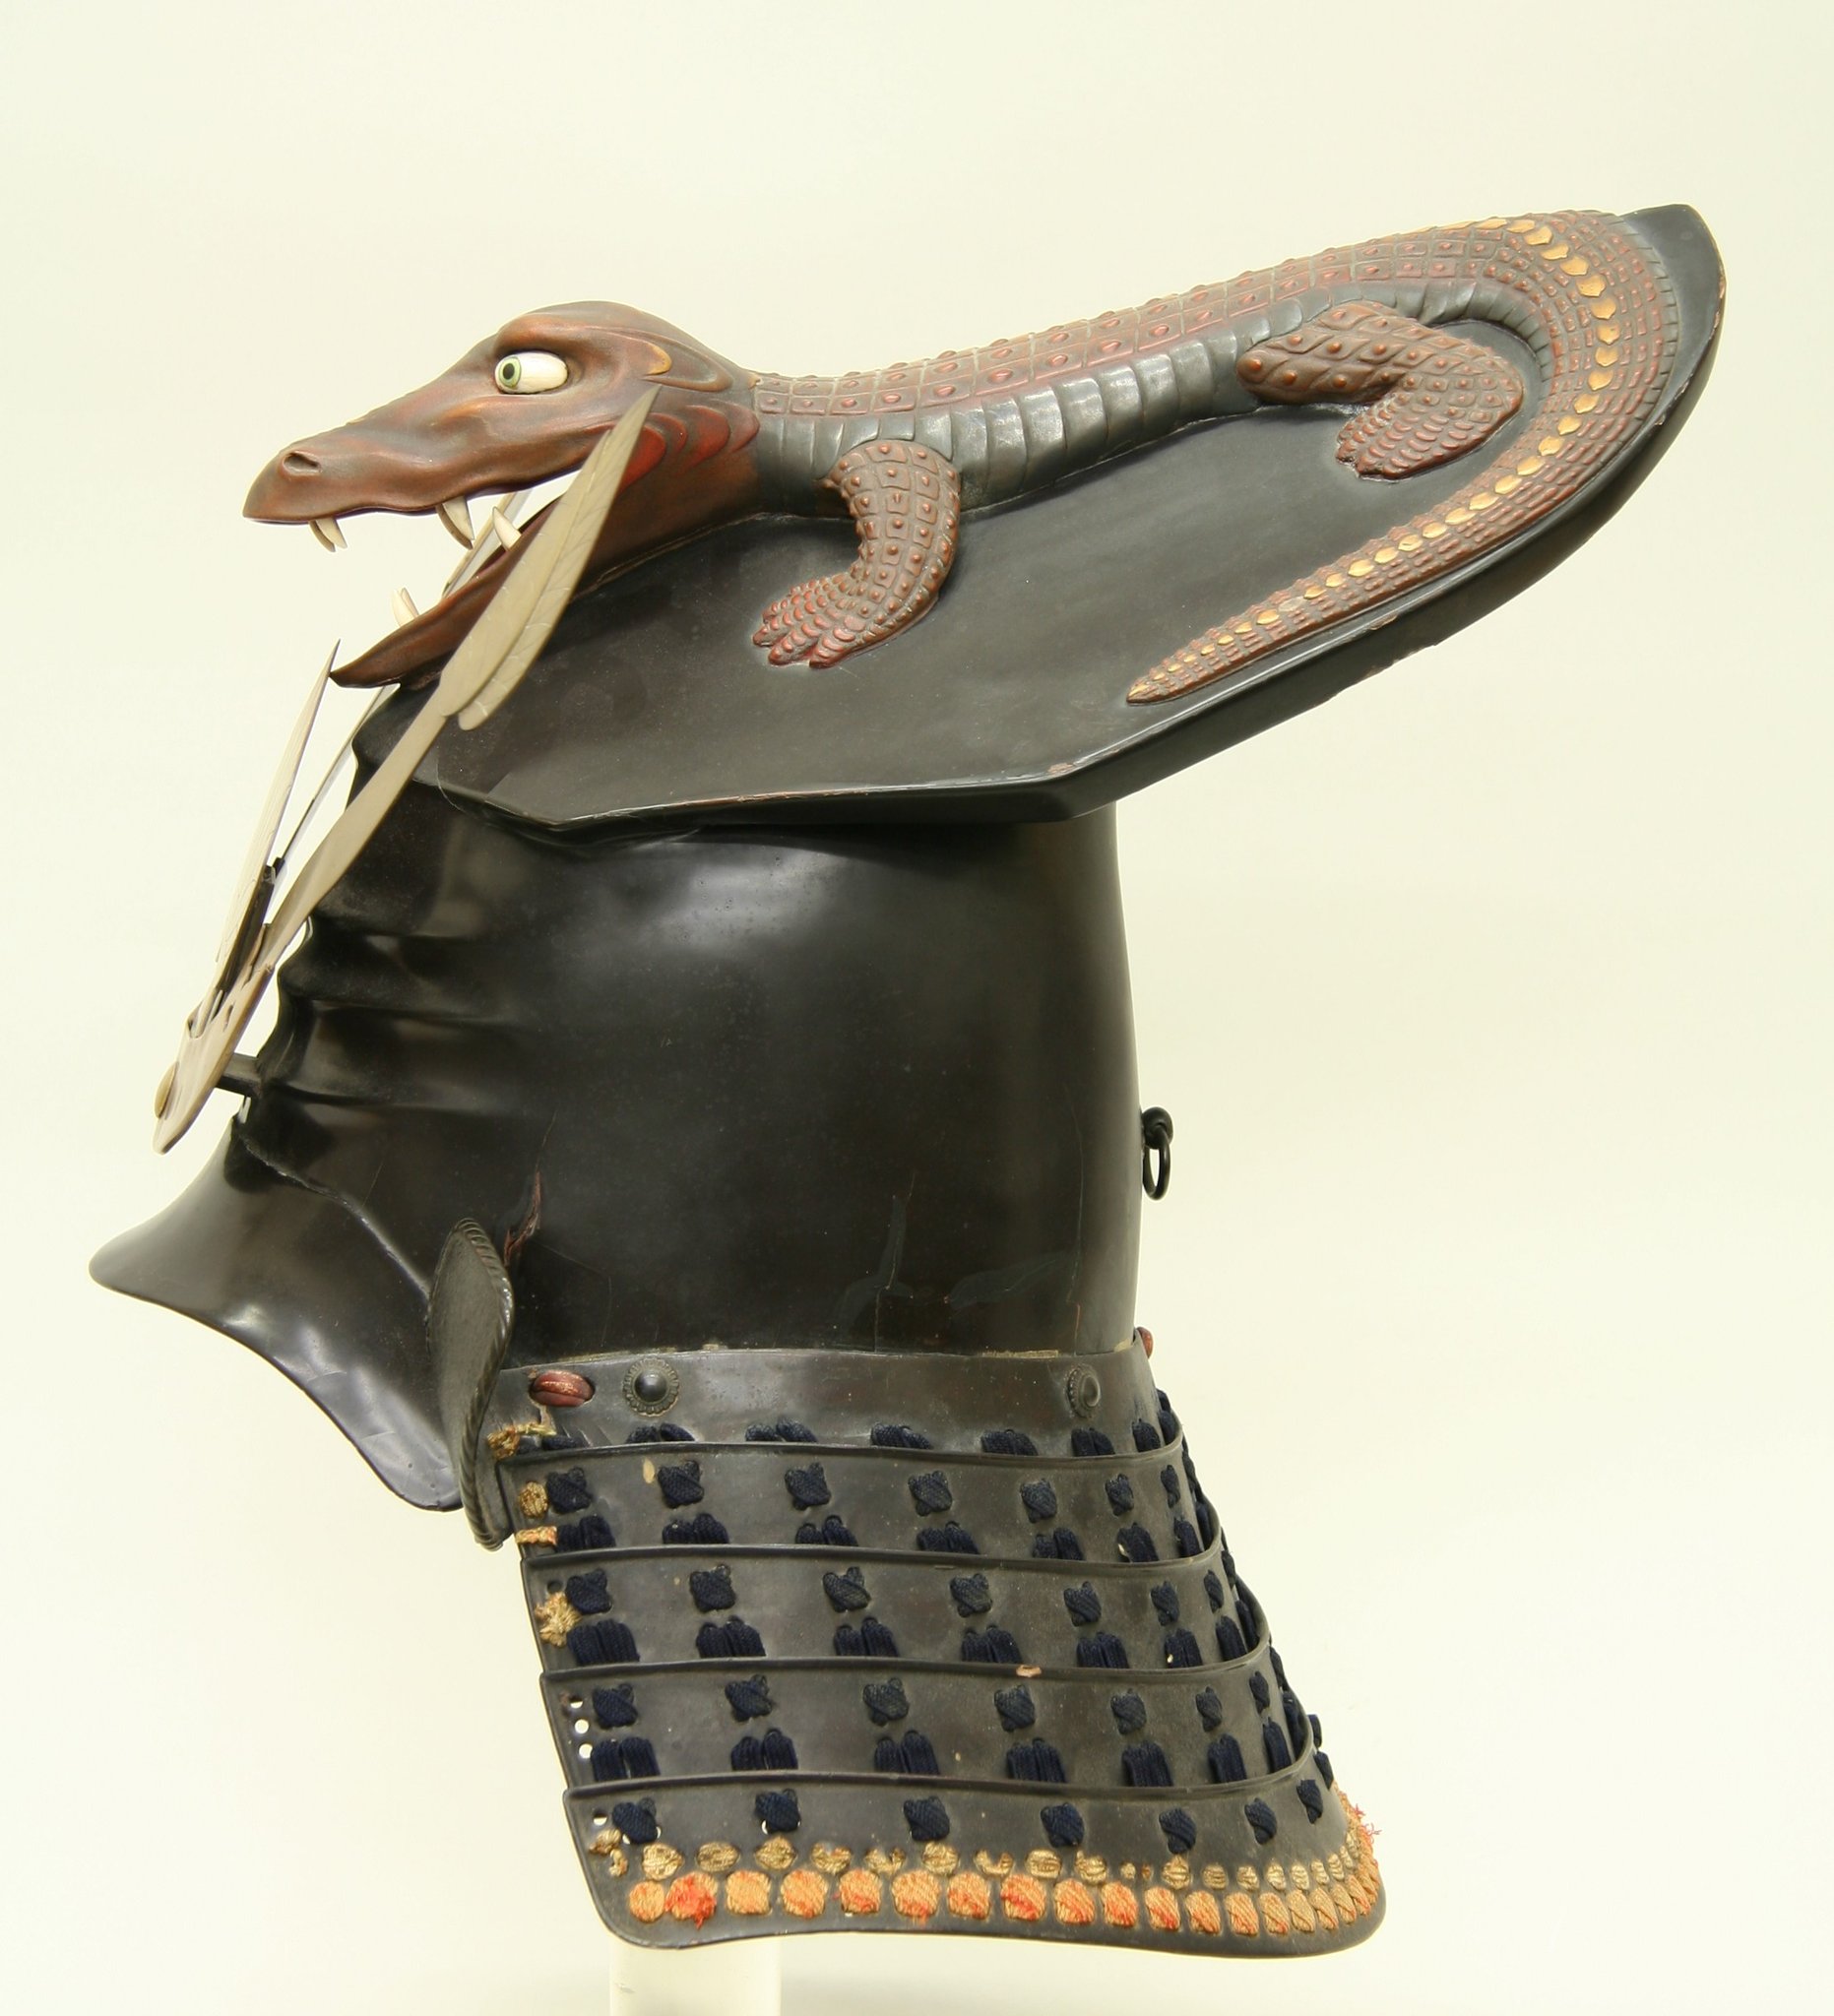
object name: helmet i kawari kabuto i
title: Helmet (Kawari Kabuto)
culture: japanese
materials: bone, gesso, iron, lacquer, leather, pigment, silk, wood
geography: japan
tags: crocodiles